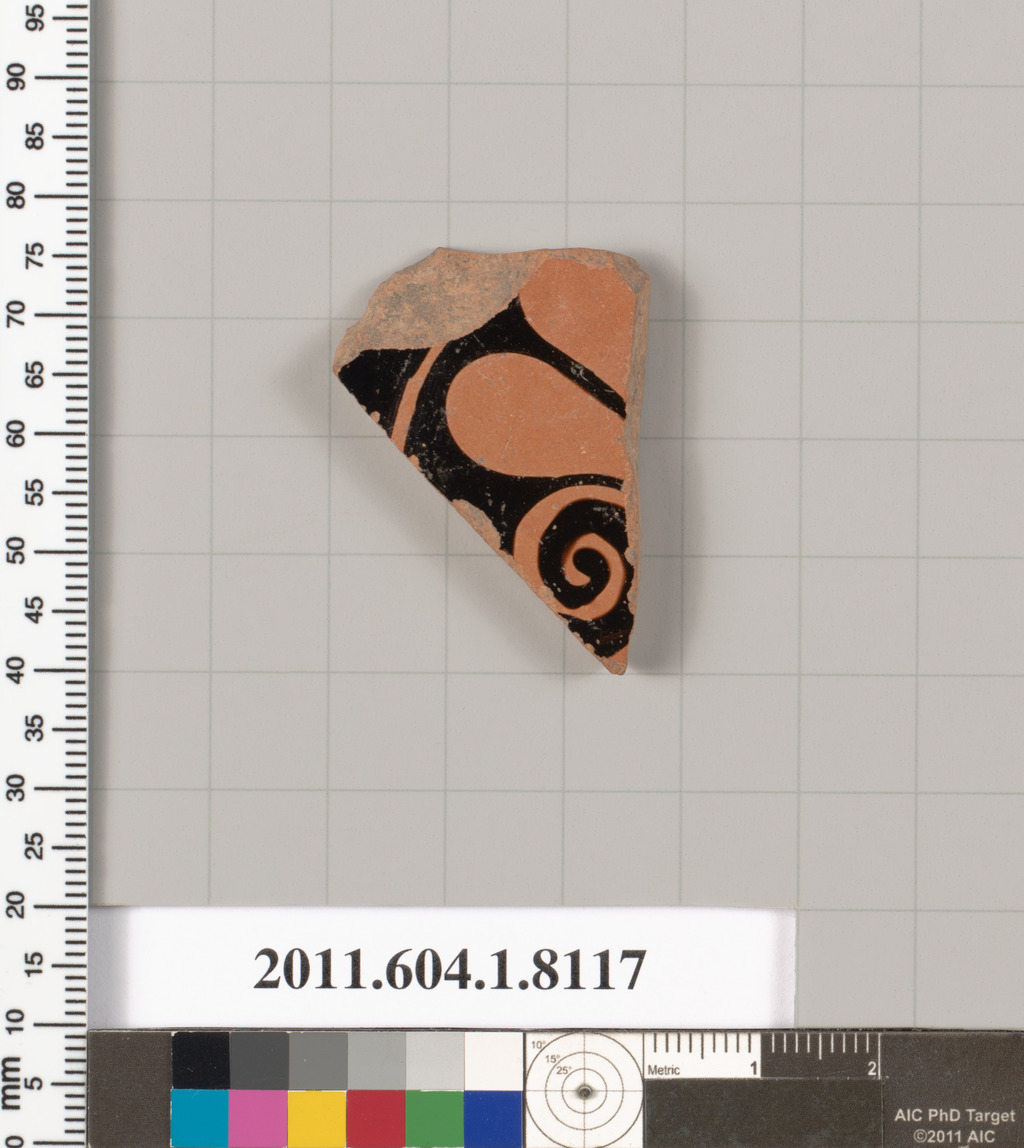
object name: kylix fragment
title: Terracotta fragment of a kylix (drinking cup)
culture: greek, attic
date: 534-468 BCE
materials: terracotta